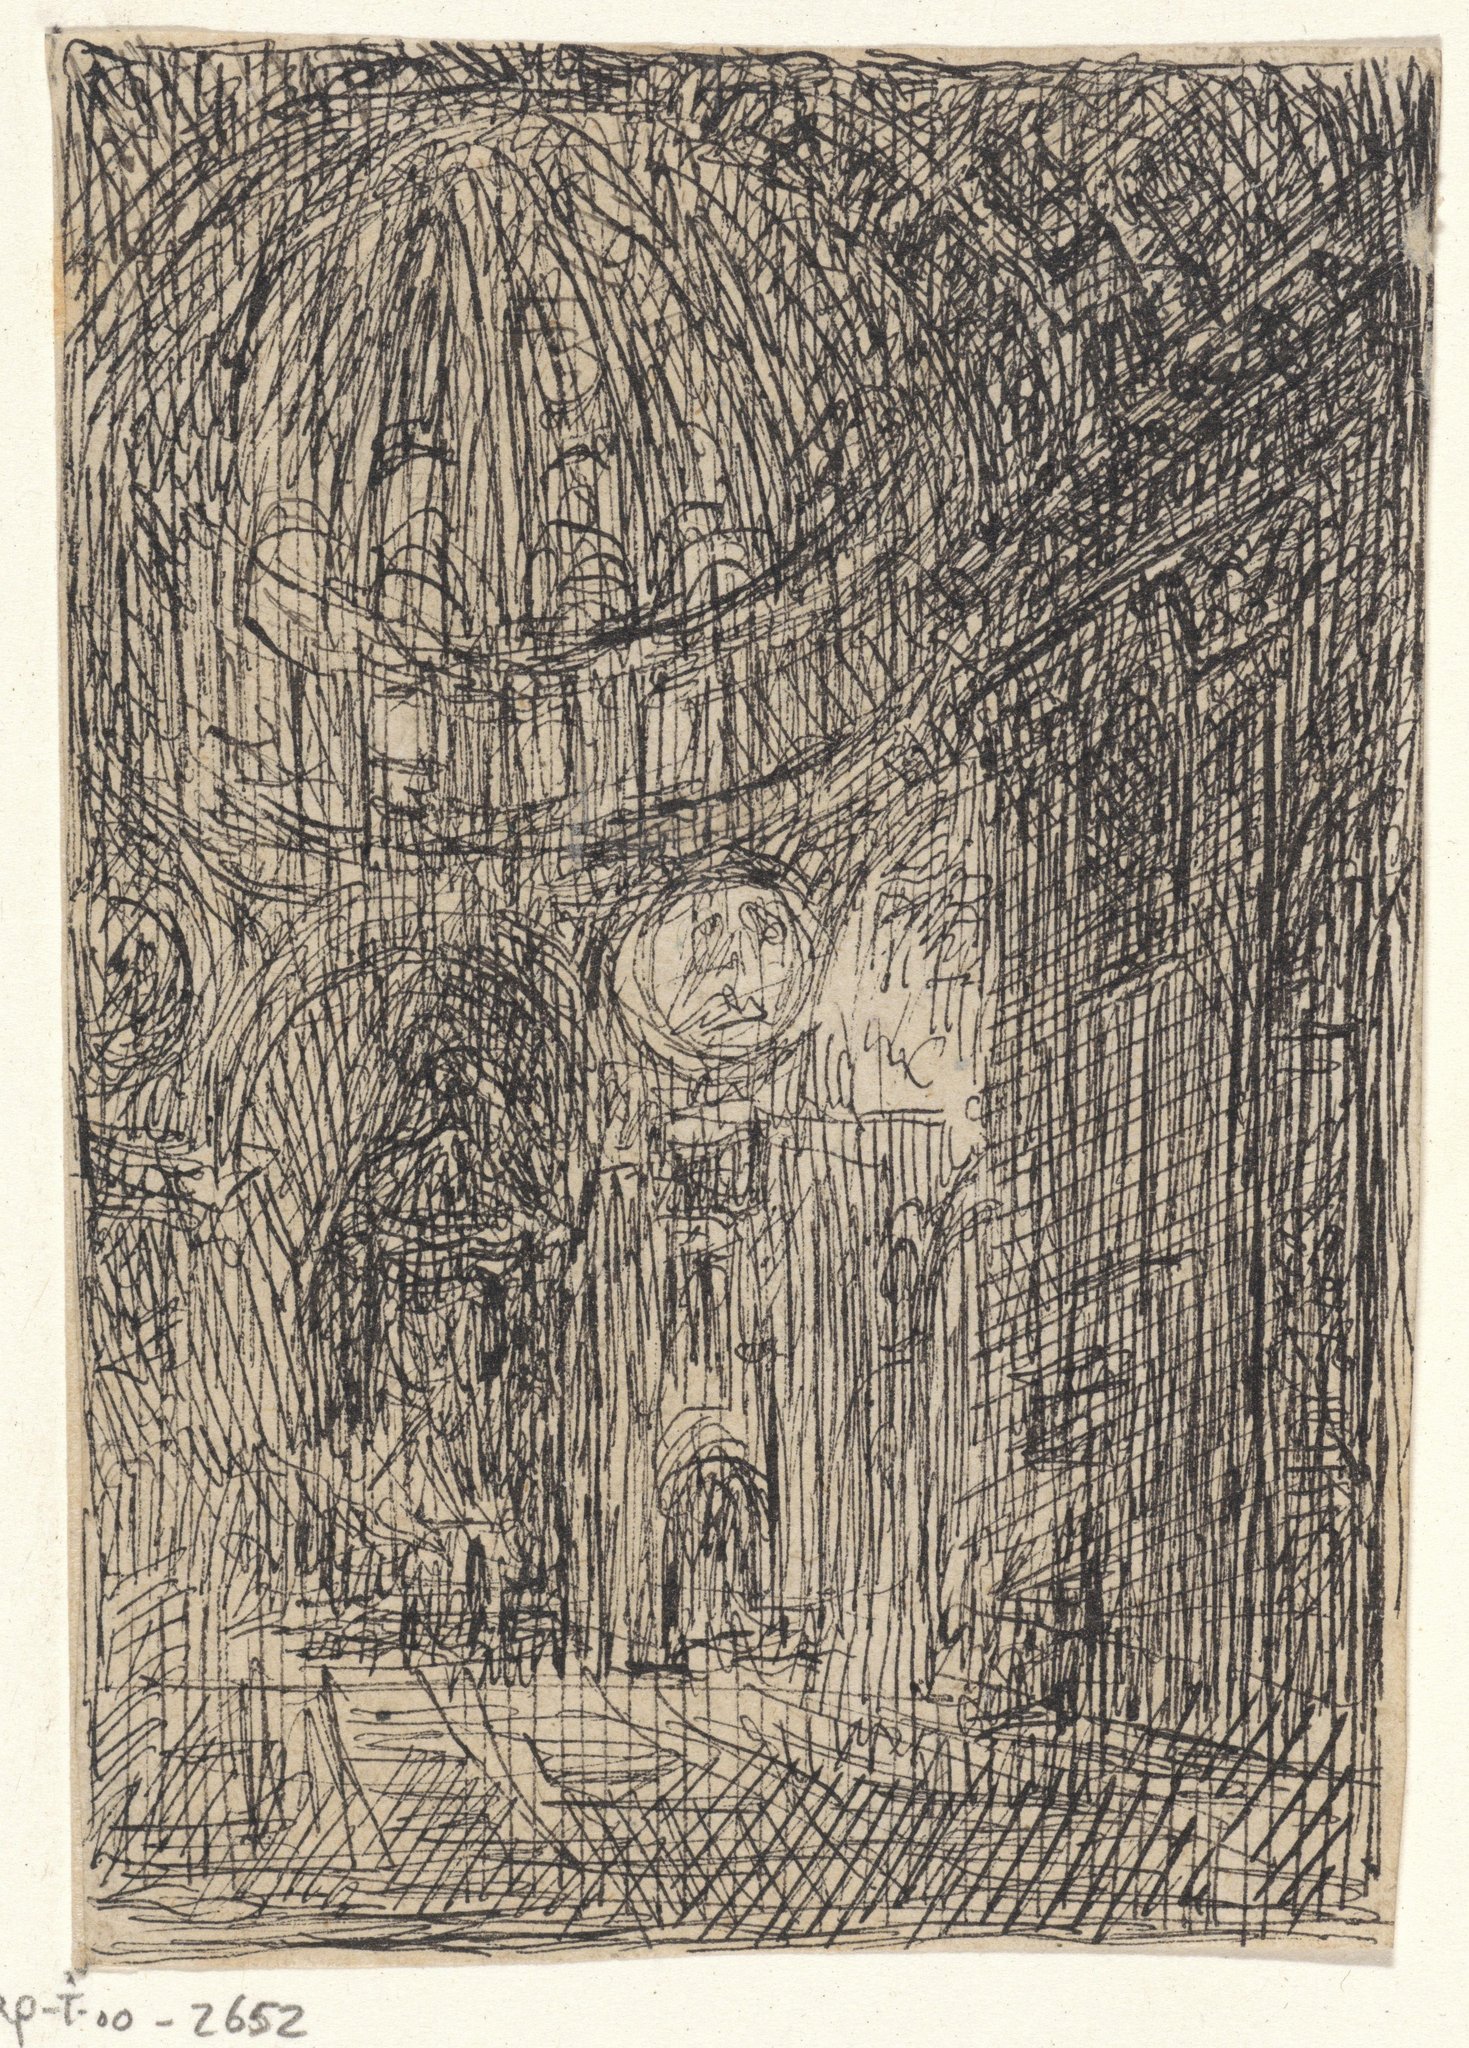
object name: drawing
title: Kerkinterieur met koepel te Rome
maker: thomas cool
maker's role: draughtsman, painter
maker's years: 1851-1904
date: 1861-1904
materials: ink, paper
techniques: pen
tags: interior of church, rome